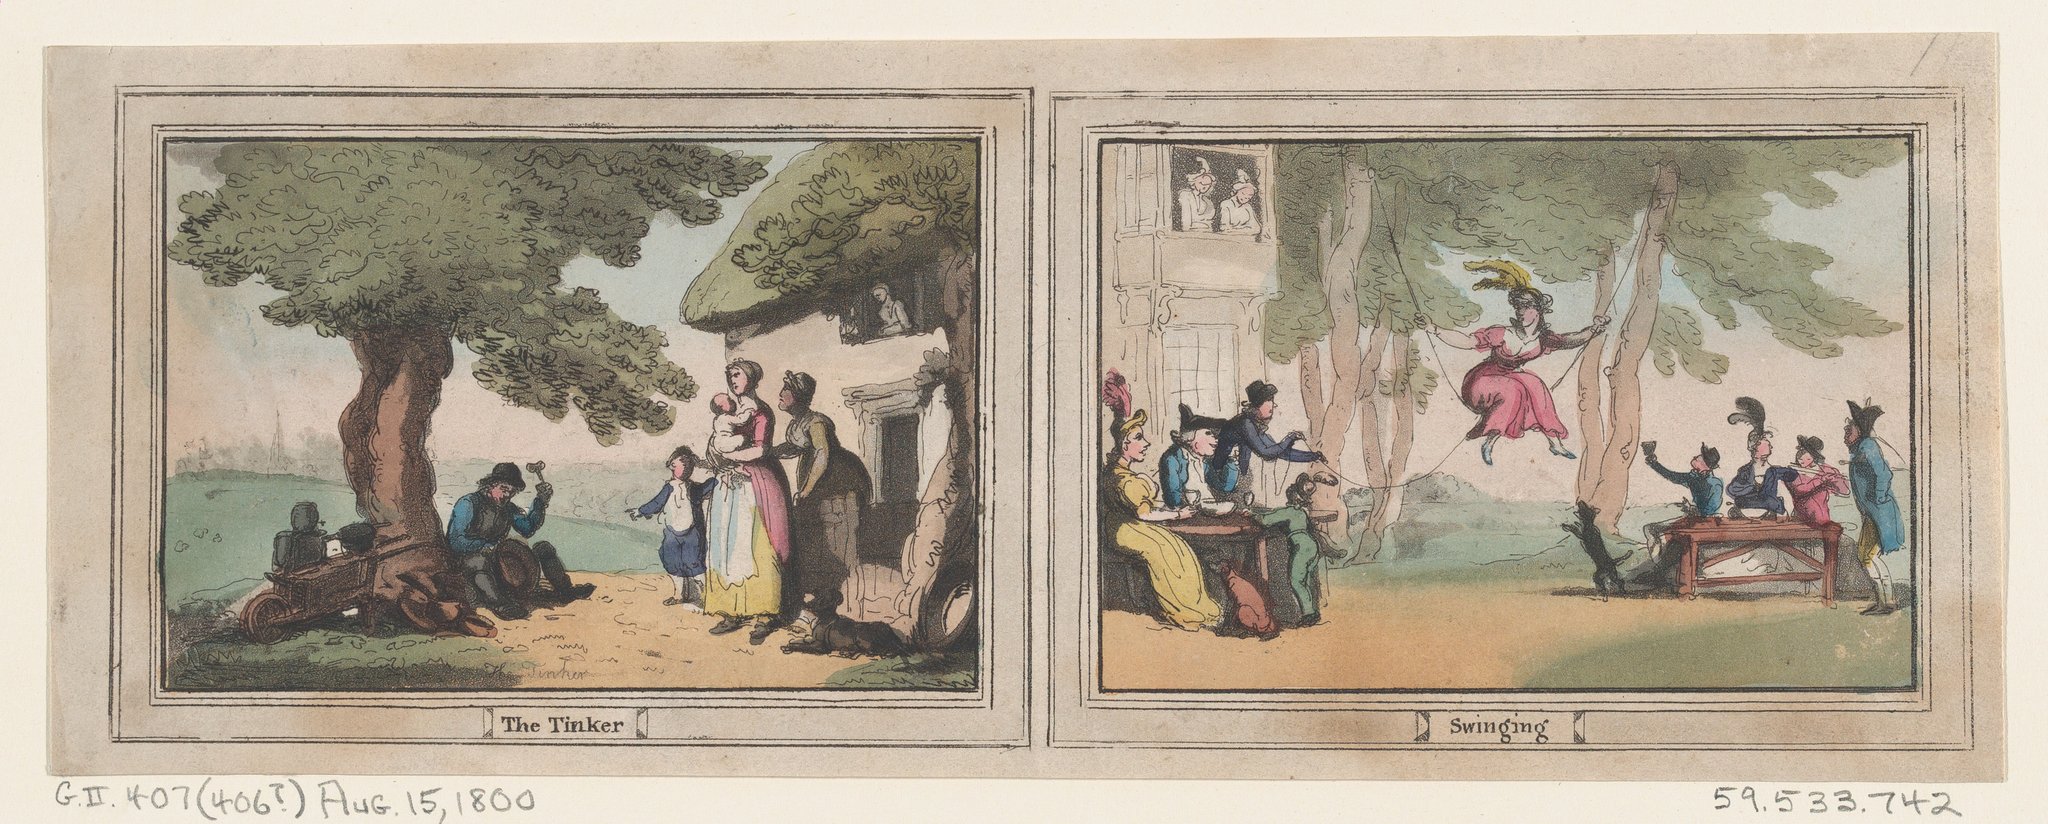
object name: print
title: The Tinker and Swinging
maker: thomas rowlandson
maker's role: artist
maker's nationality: british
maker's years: 1757-1827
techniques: etching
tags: men,women,working